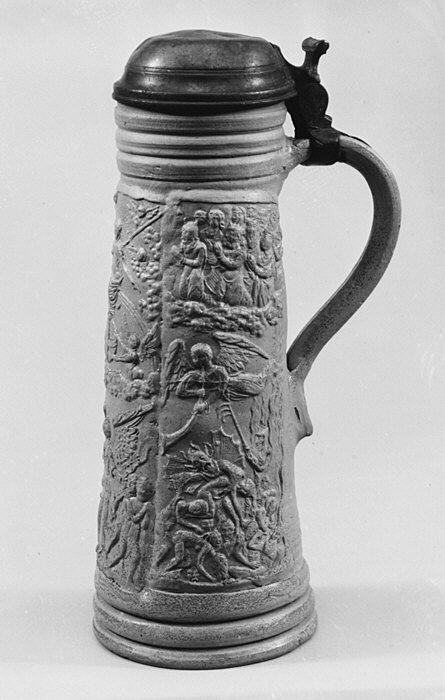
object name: tankard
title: Tankard (Schnelle) with The Last Judgment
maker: f. trac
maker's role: maker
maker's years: 1559-1568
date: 1501-1600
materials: pewter, stoneware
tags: angels,demons,last judgement